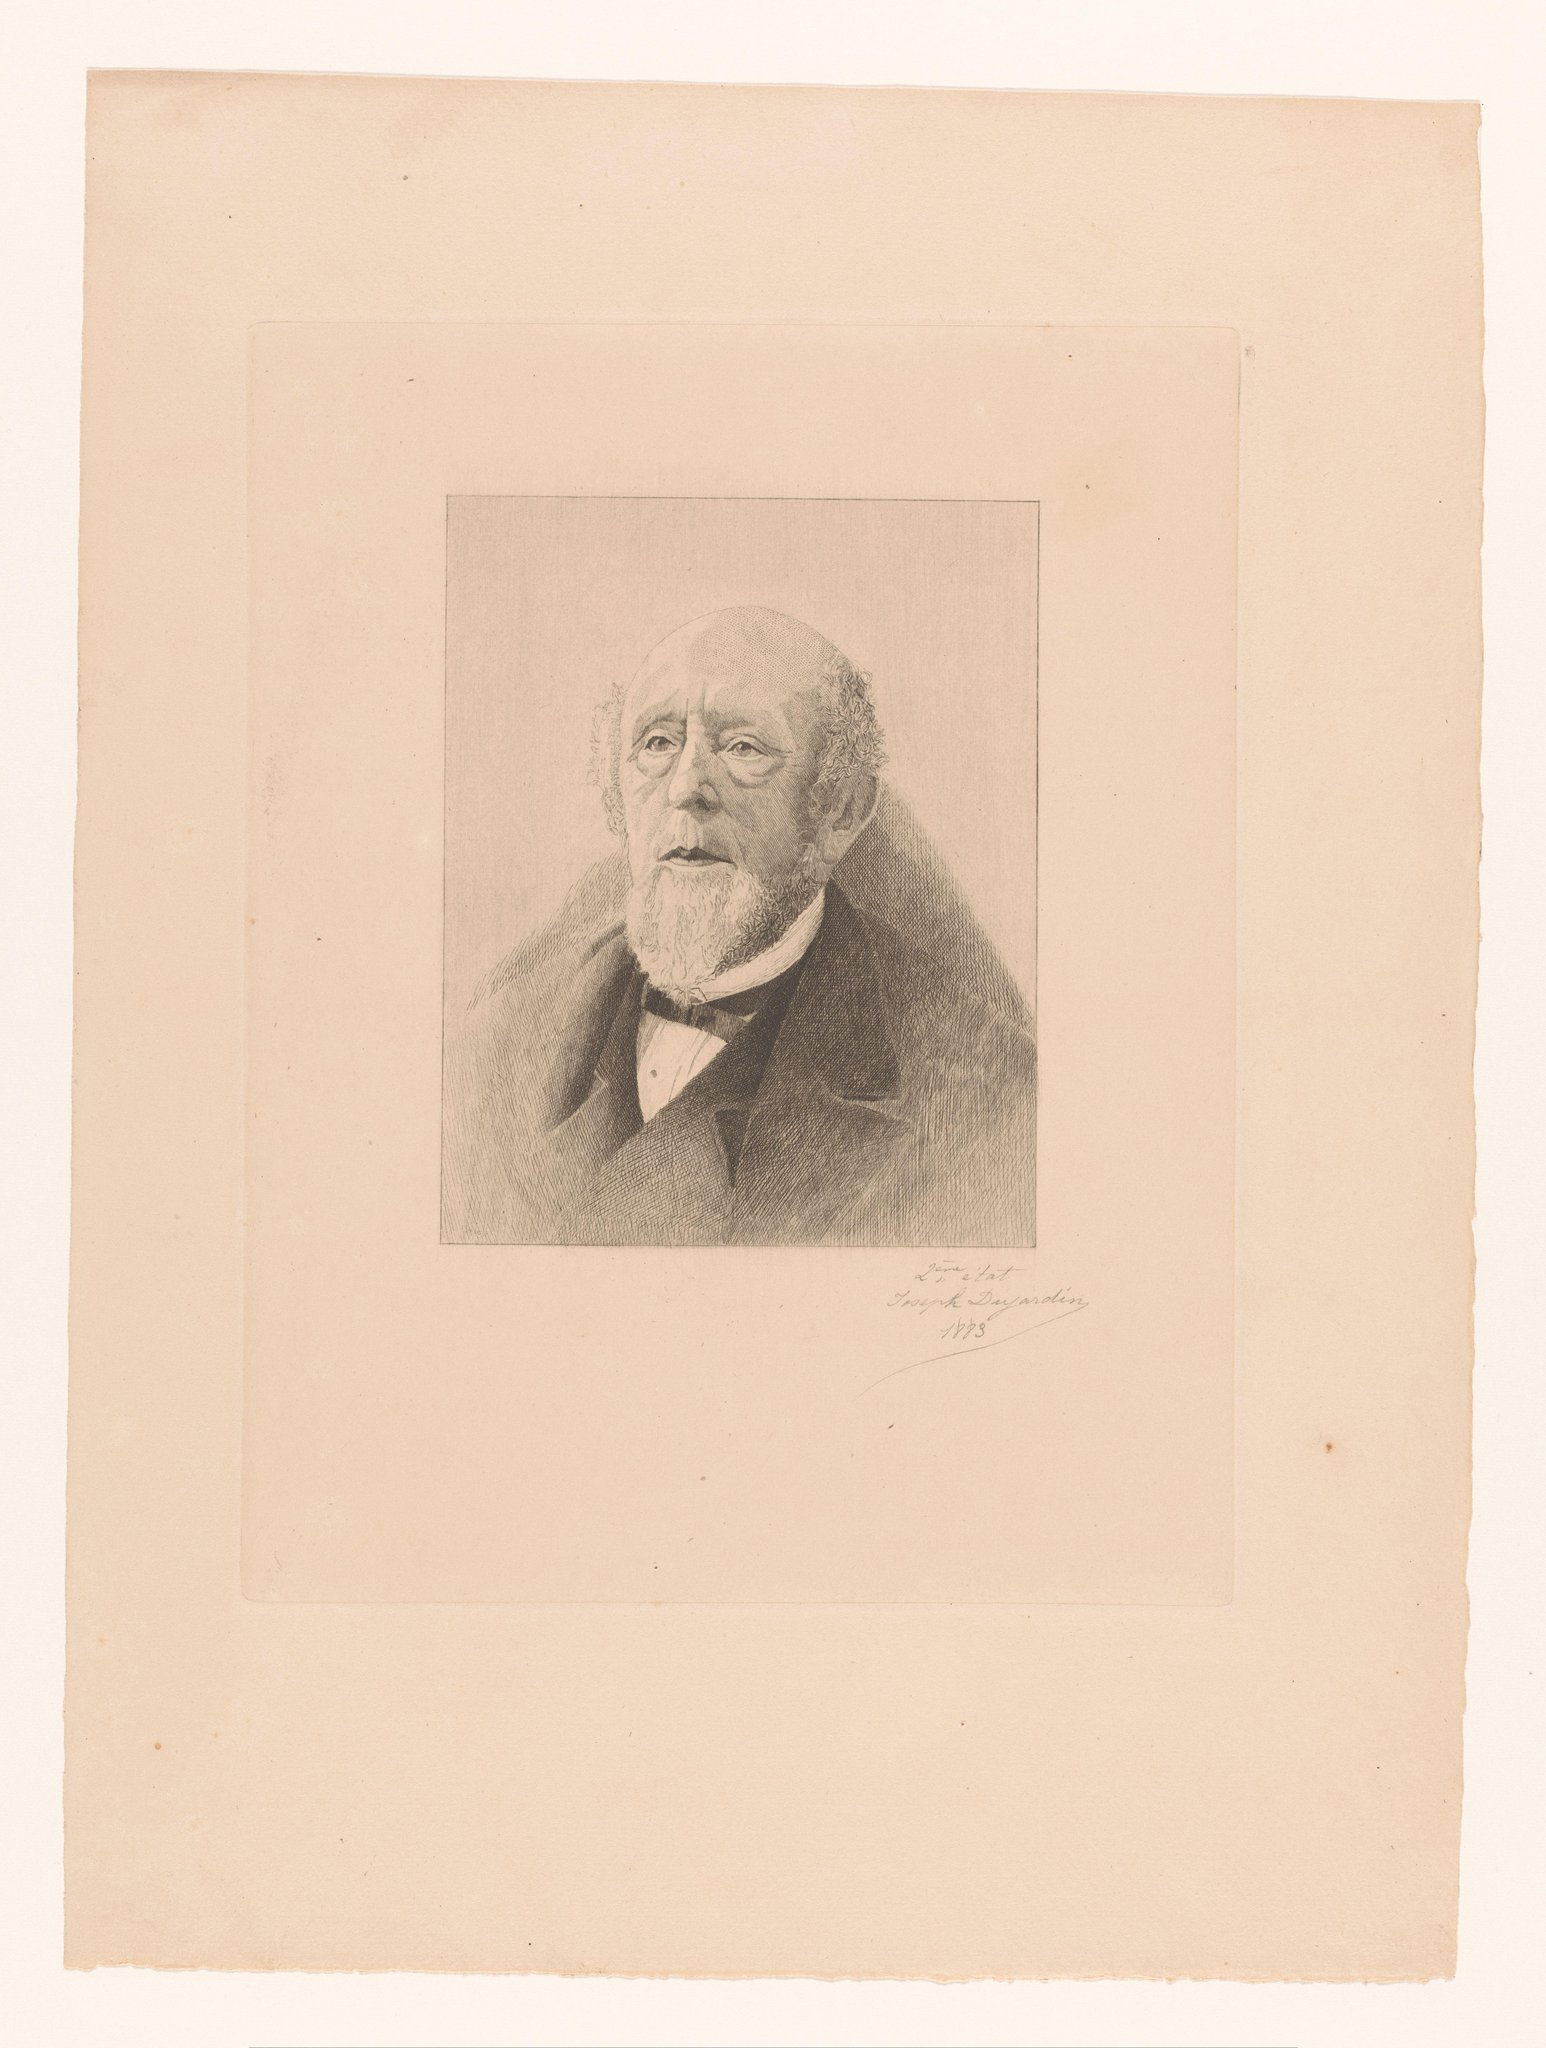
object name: print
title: Portret van een onbekende man, mogelijk Bourlard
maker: joseph dujardin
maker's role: print maker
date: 1883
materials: paper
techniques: etching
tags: adult man, historical persons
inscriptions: collector's mark: Lugt 2228, inscription: ‘2éme état’